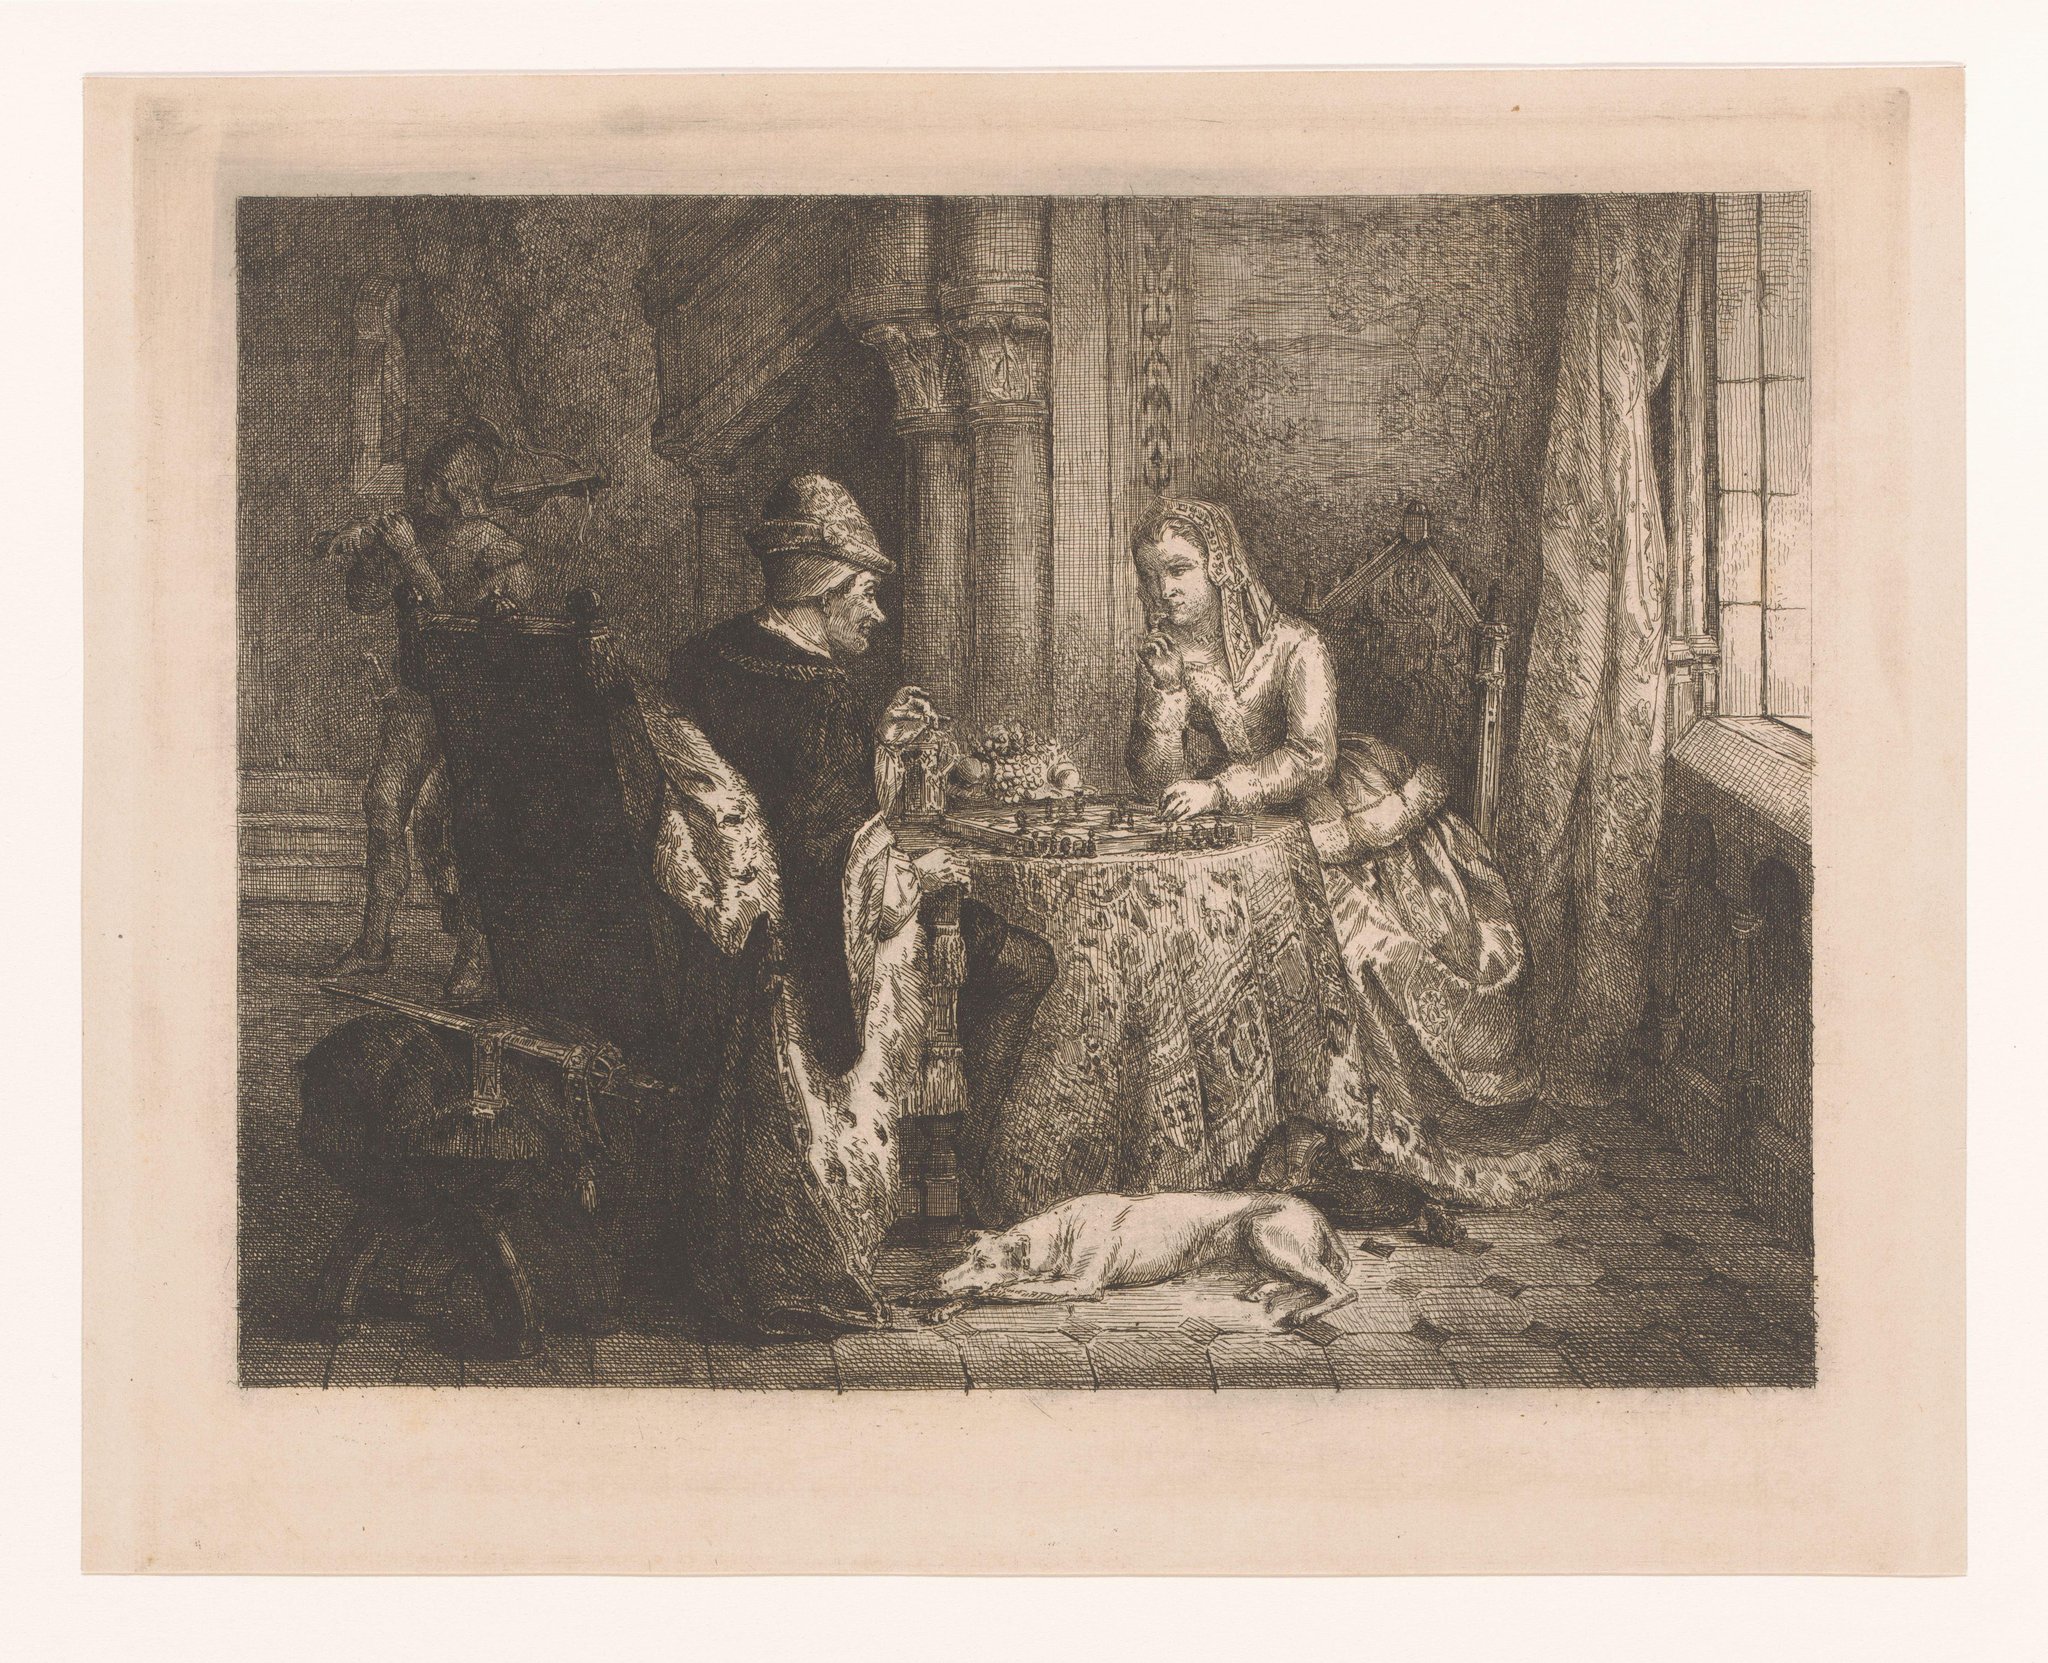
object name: print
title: Lodewijk XI en zijn dochter Anna van Beaujeu spelen schaak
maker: adrien joseph verhoeven-ball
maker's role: draughtsman, print maker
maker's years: 1824-1882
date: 1866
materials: paper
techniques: drypoint, etching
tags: genappe, chess, historical persons, king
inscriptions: collector's mark: Lugt 1485, collector's mark: Lugt 2228